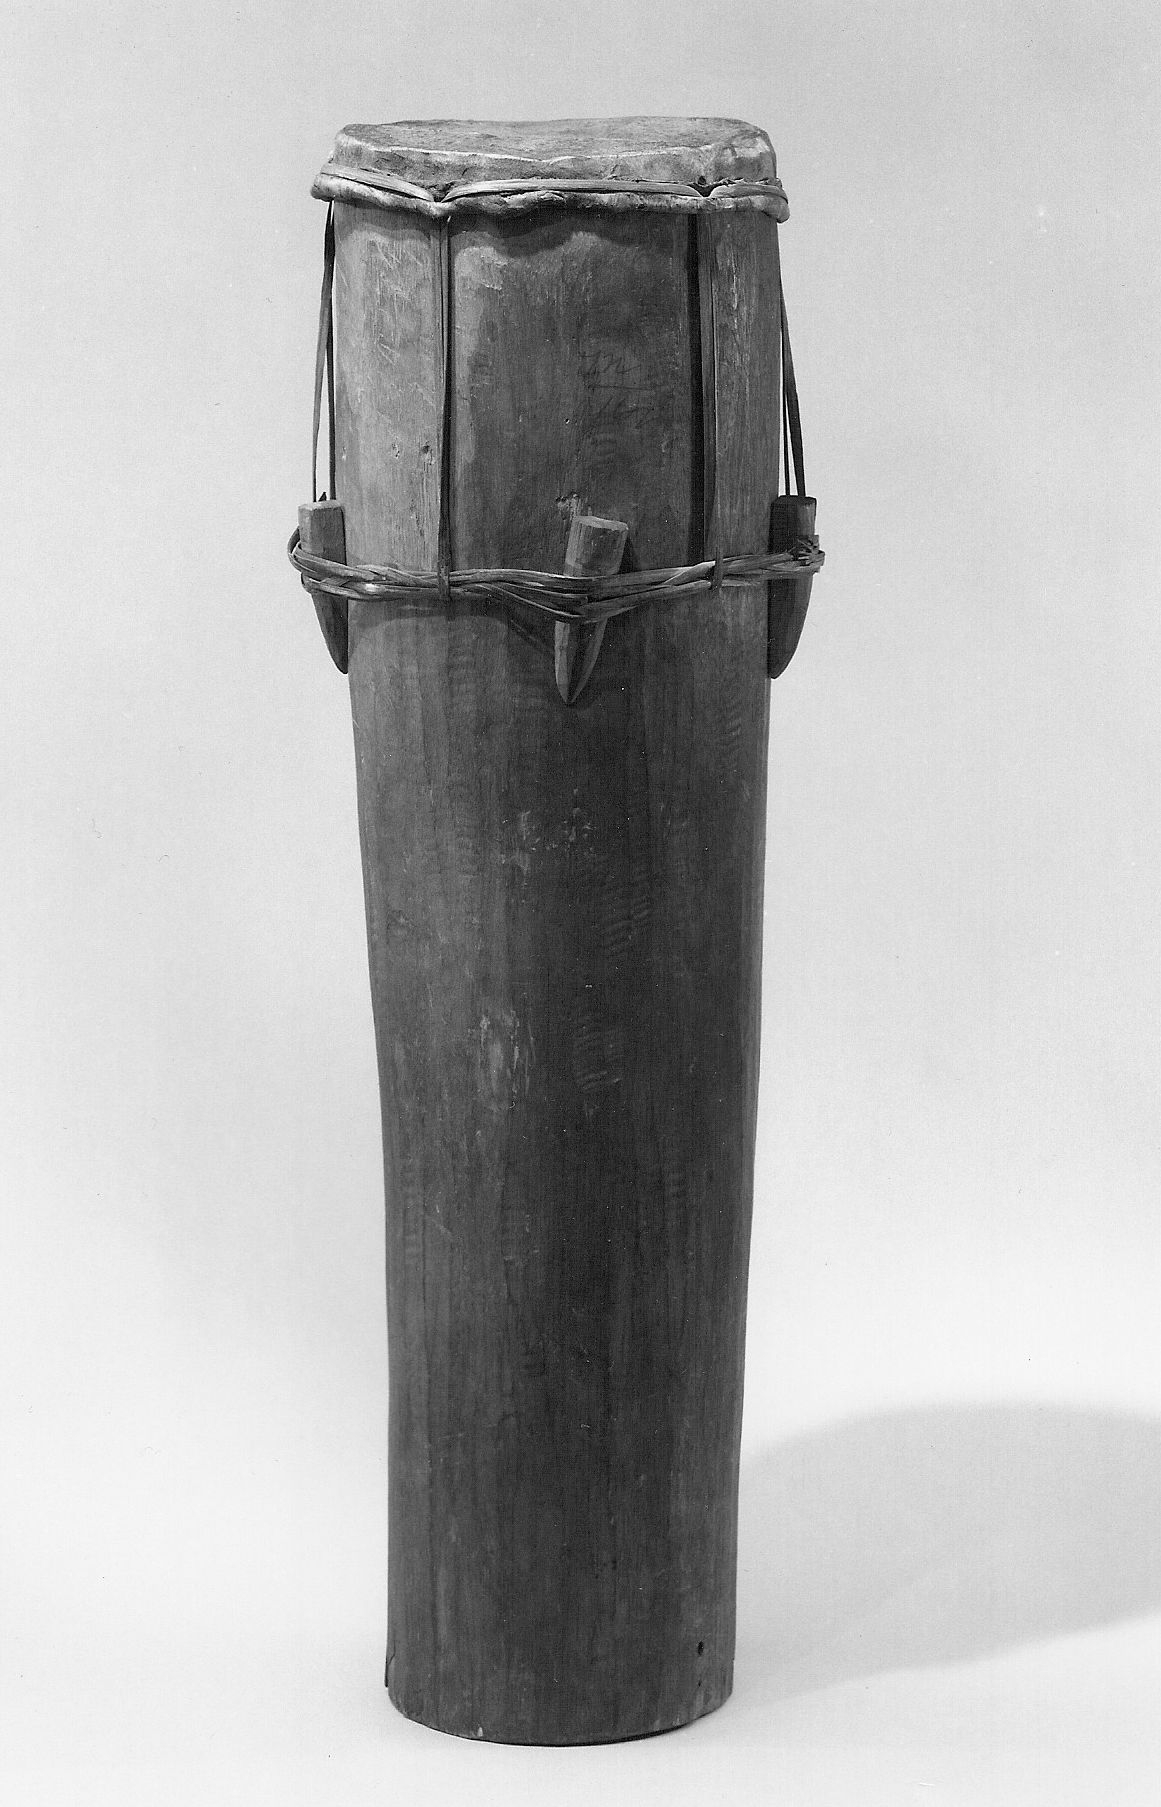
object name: drum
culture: south african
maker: zulu people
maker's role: maker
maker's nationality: south african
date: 1801-1900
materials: fiber, wood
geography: south africa